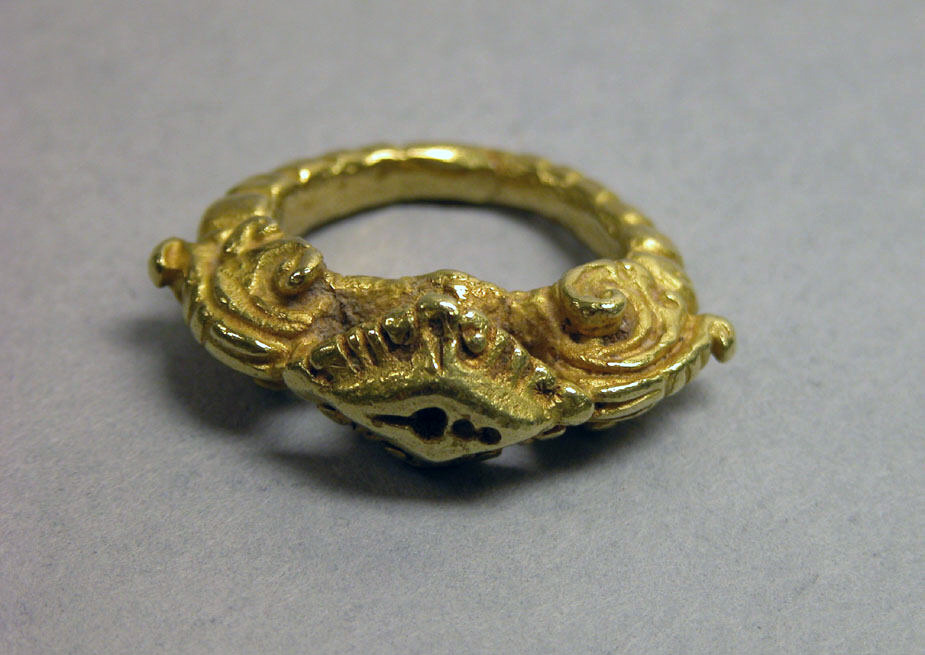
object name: ring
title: Stirrup-shaped Ring with Lozenge-shaped Bezel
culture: indonesian, javanese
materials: gold